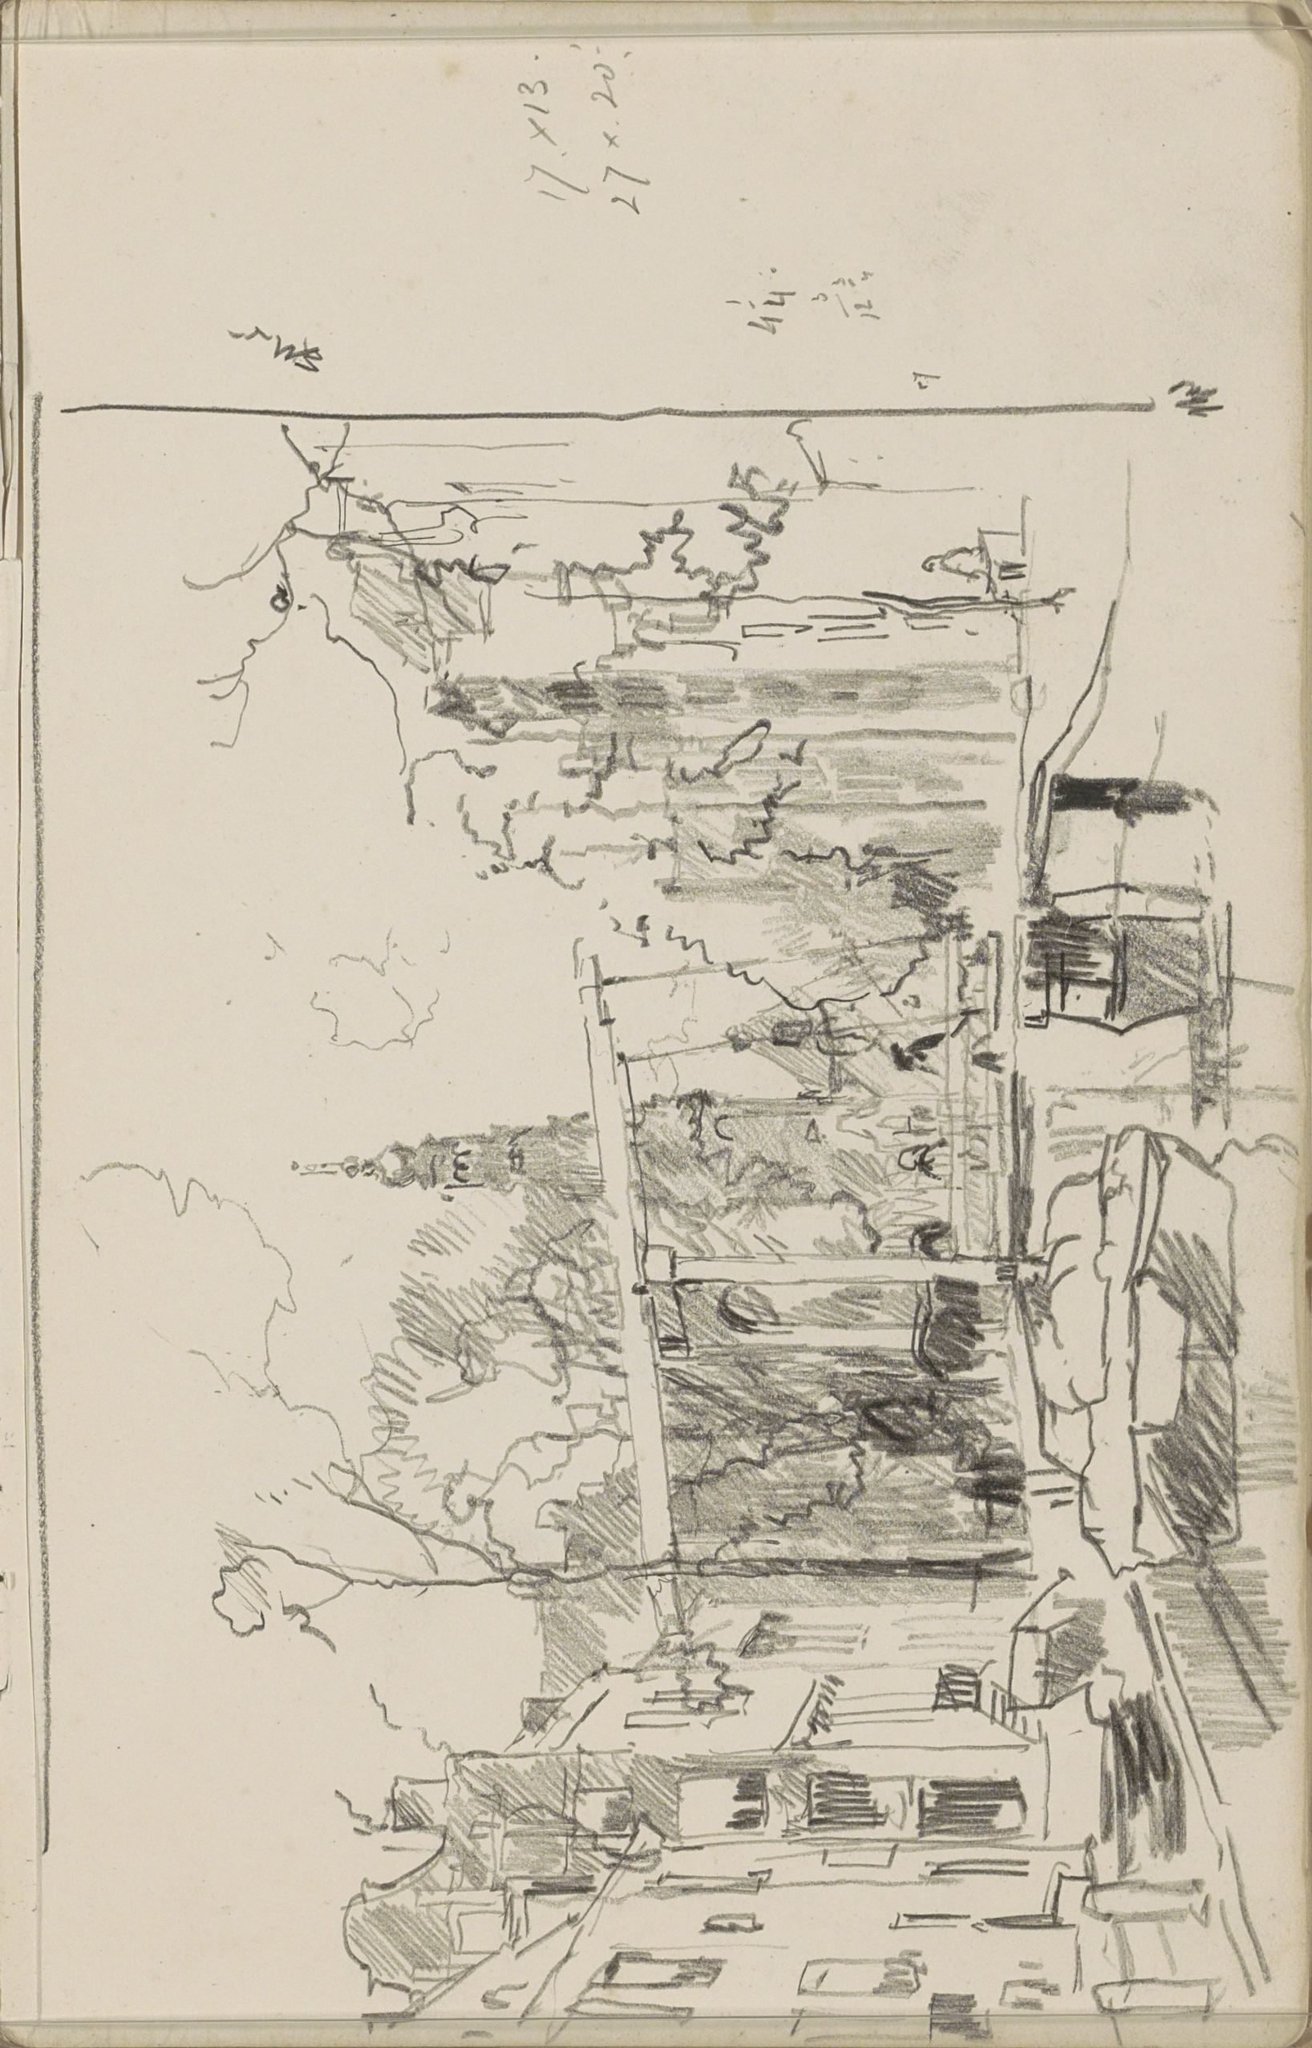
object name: sketchbook leaf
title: Gracht met een ophaalbrug te Amsterdam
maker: cornelis vreedenburgh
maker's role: draughtsman, print maker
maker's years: 1880-1946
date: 1890-1946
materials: paper, pencil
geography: amsterdam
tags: bridge in city across river, canal, etc., amsterdam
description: Blad 2 recto uit een schetsboek met 45 bladen.